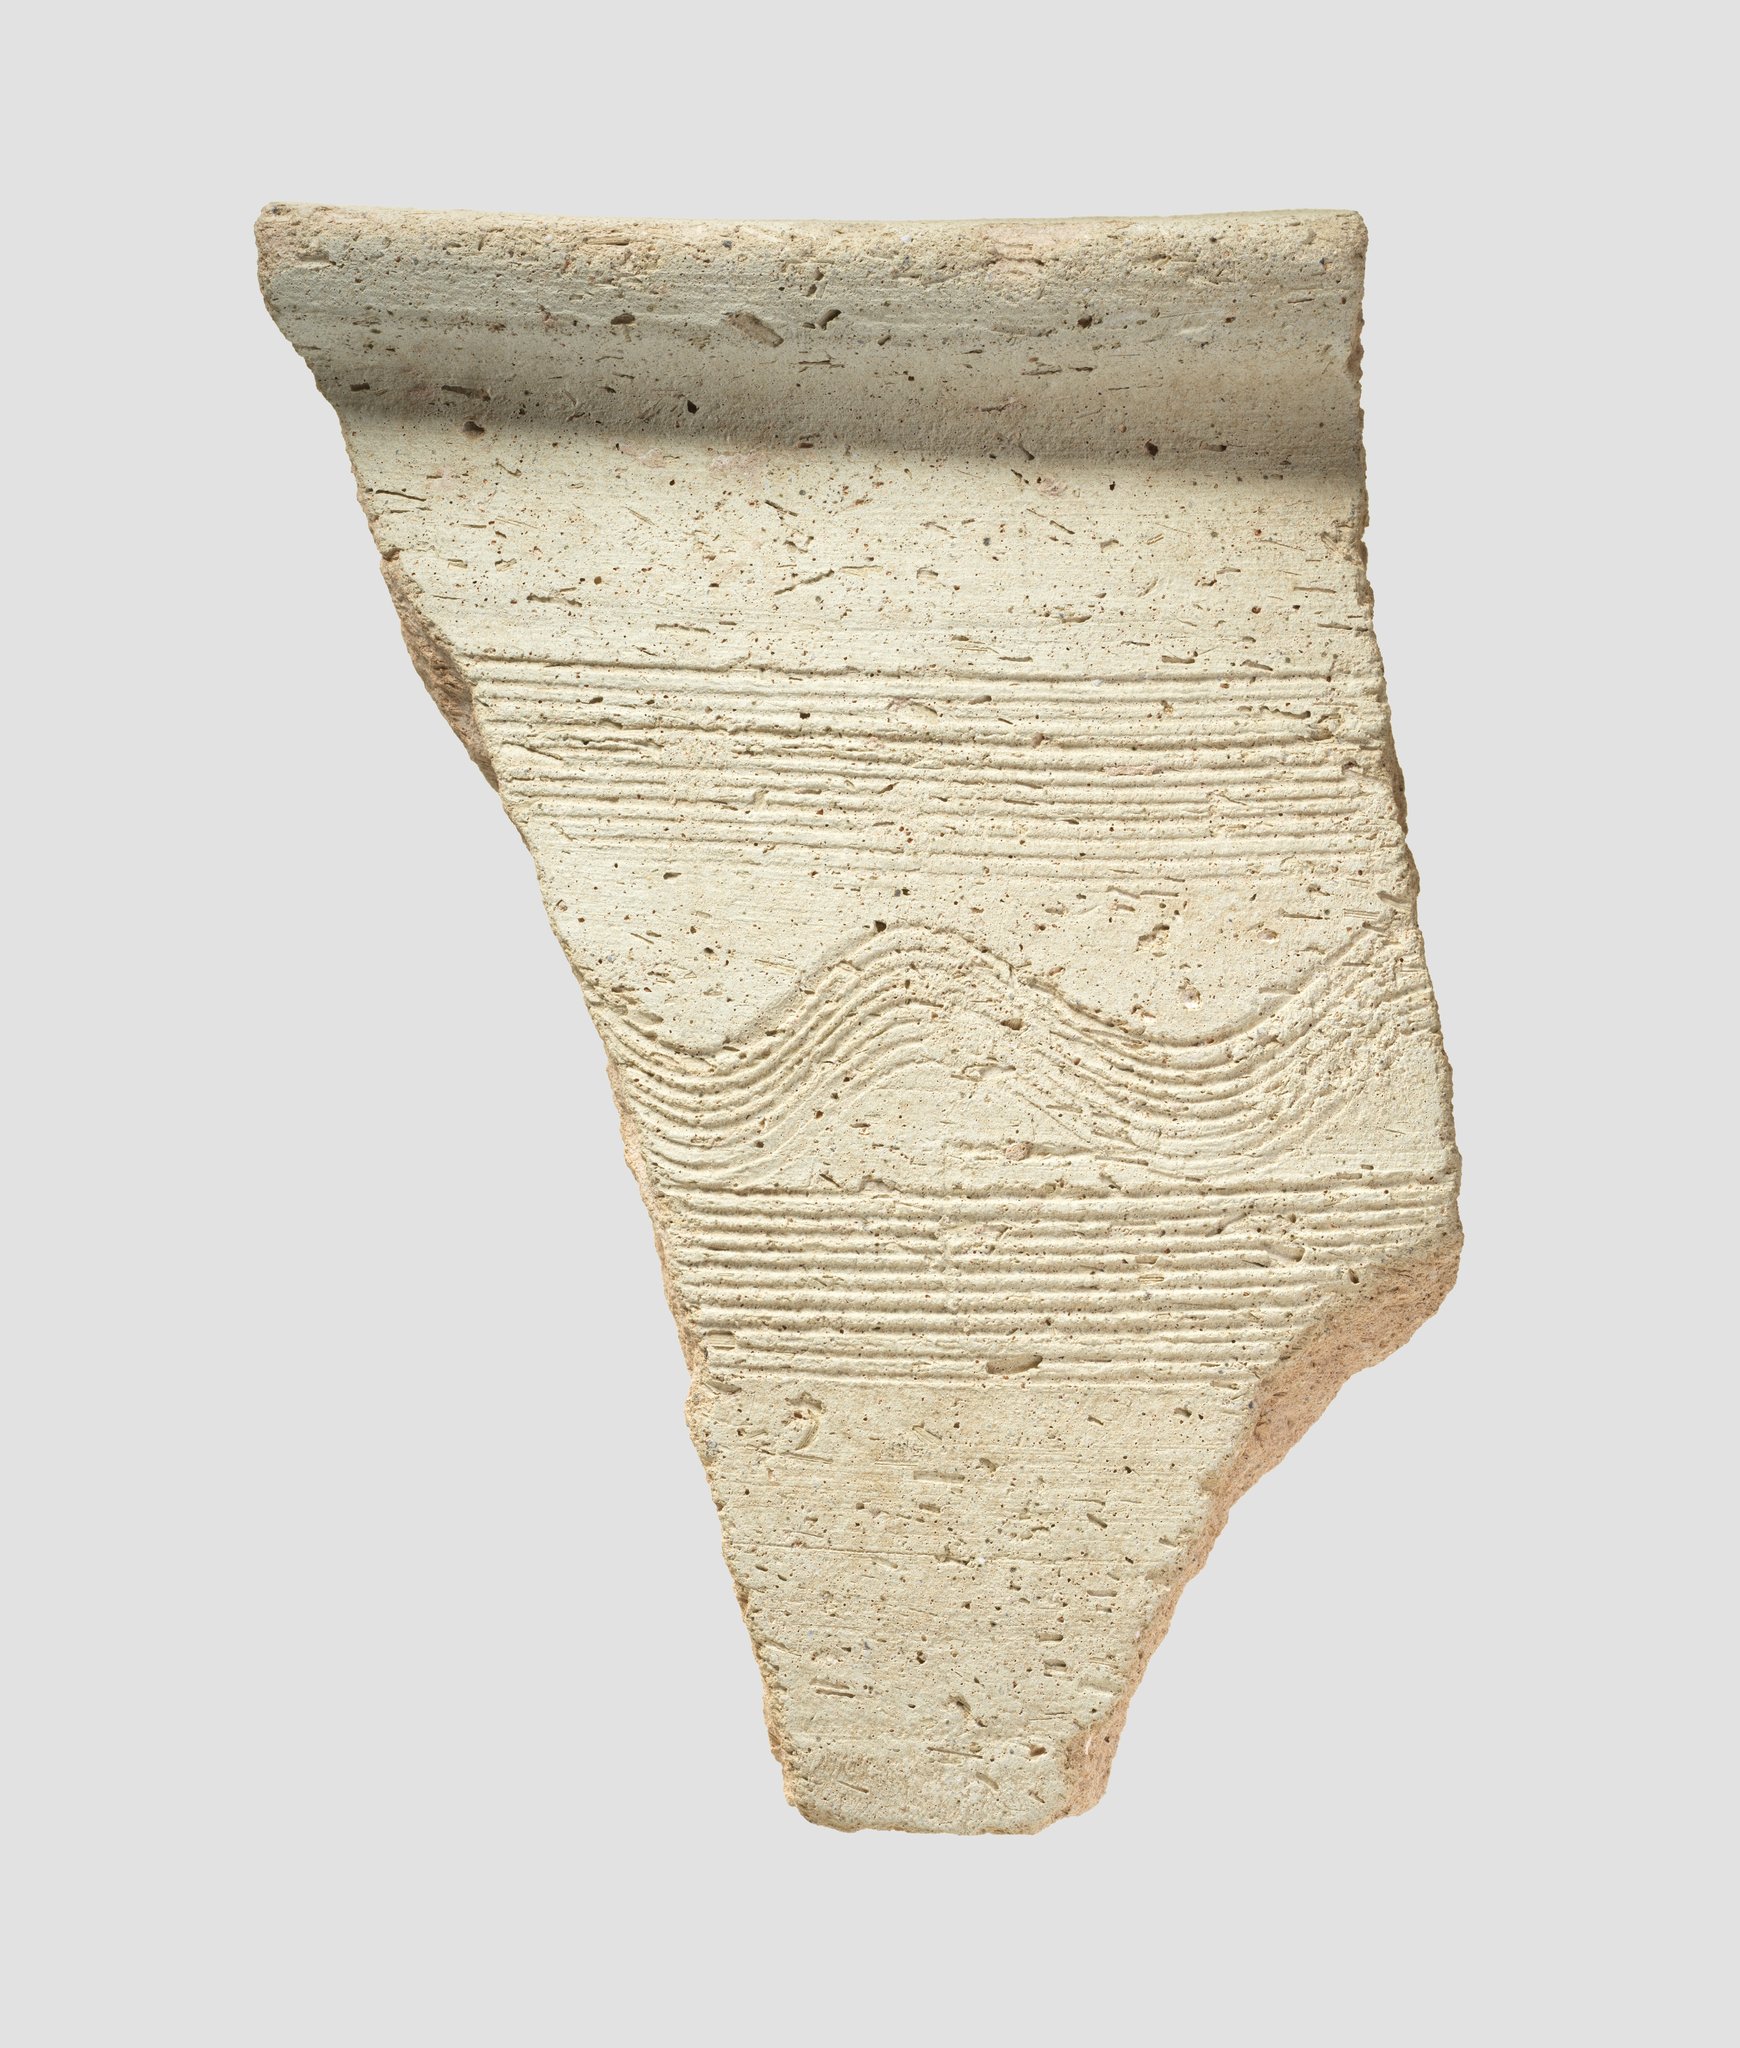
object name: sherd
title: Rim sherd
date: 2333-2001 BCE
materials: ceramic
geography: mesopotamia